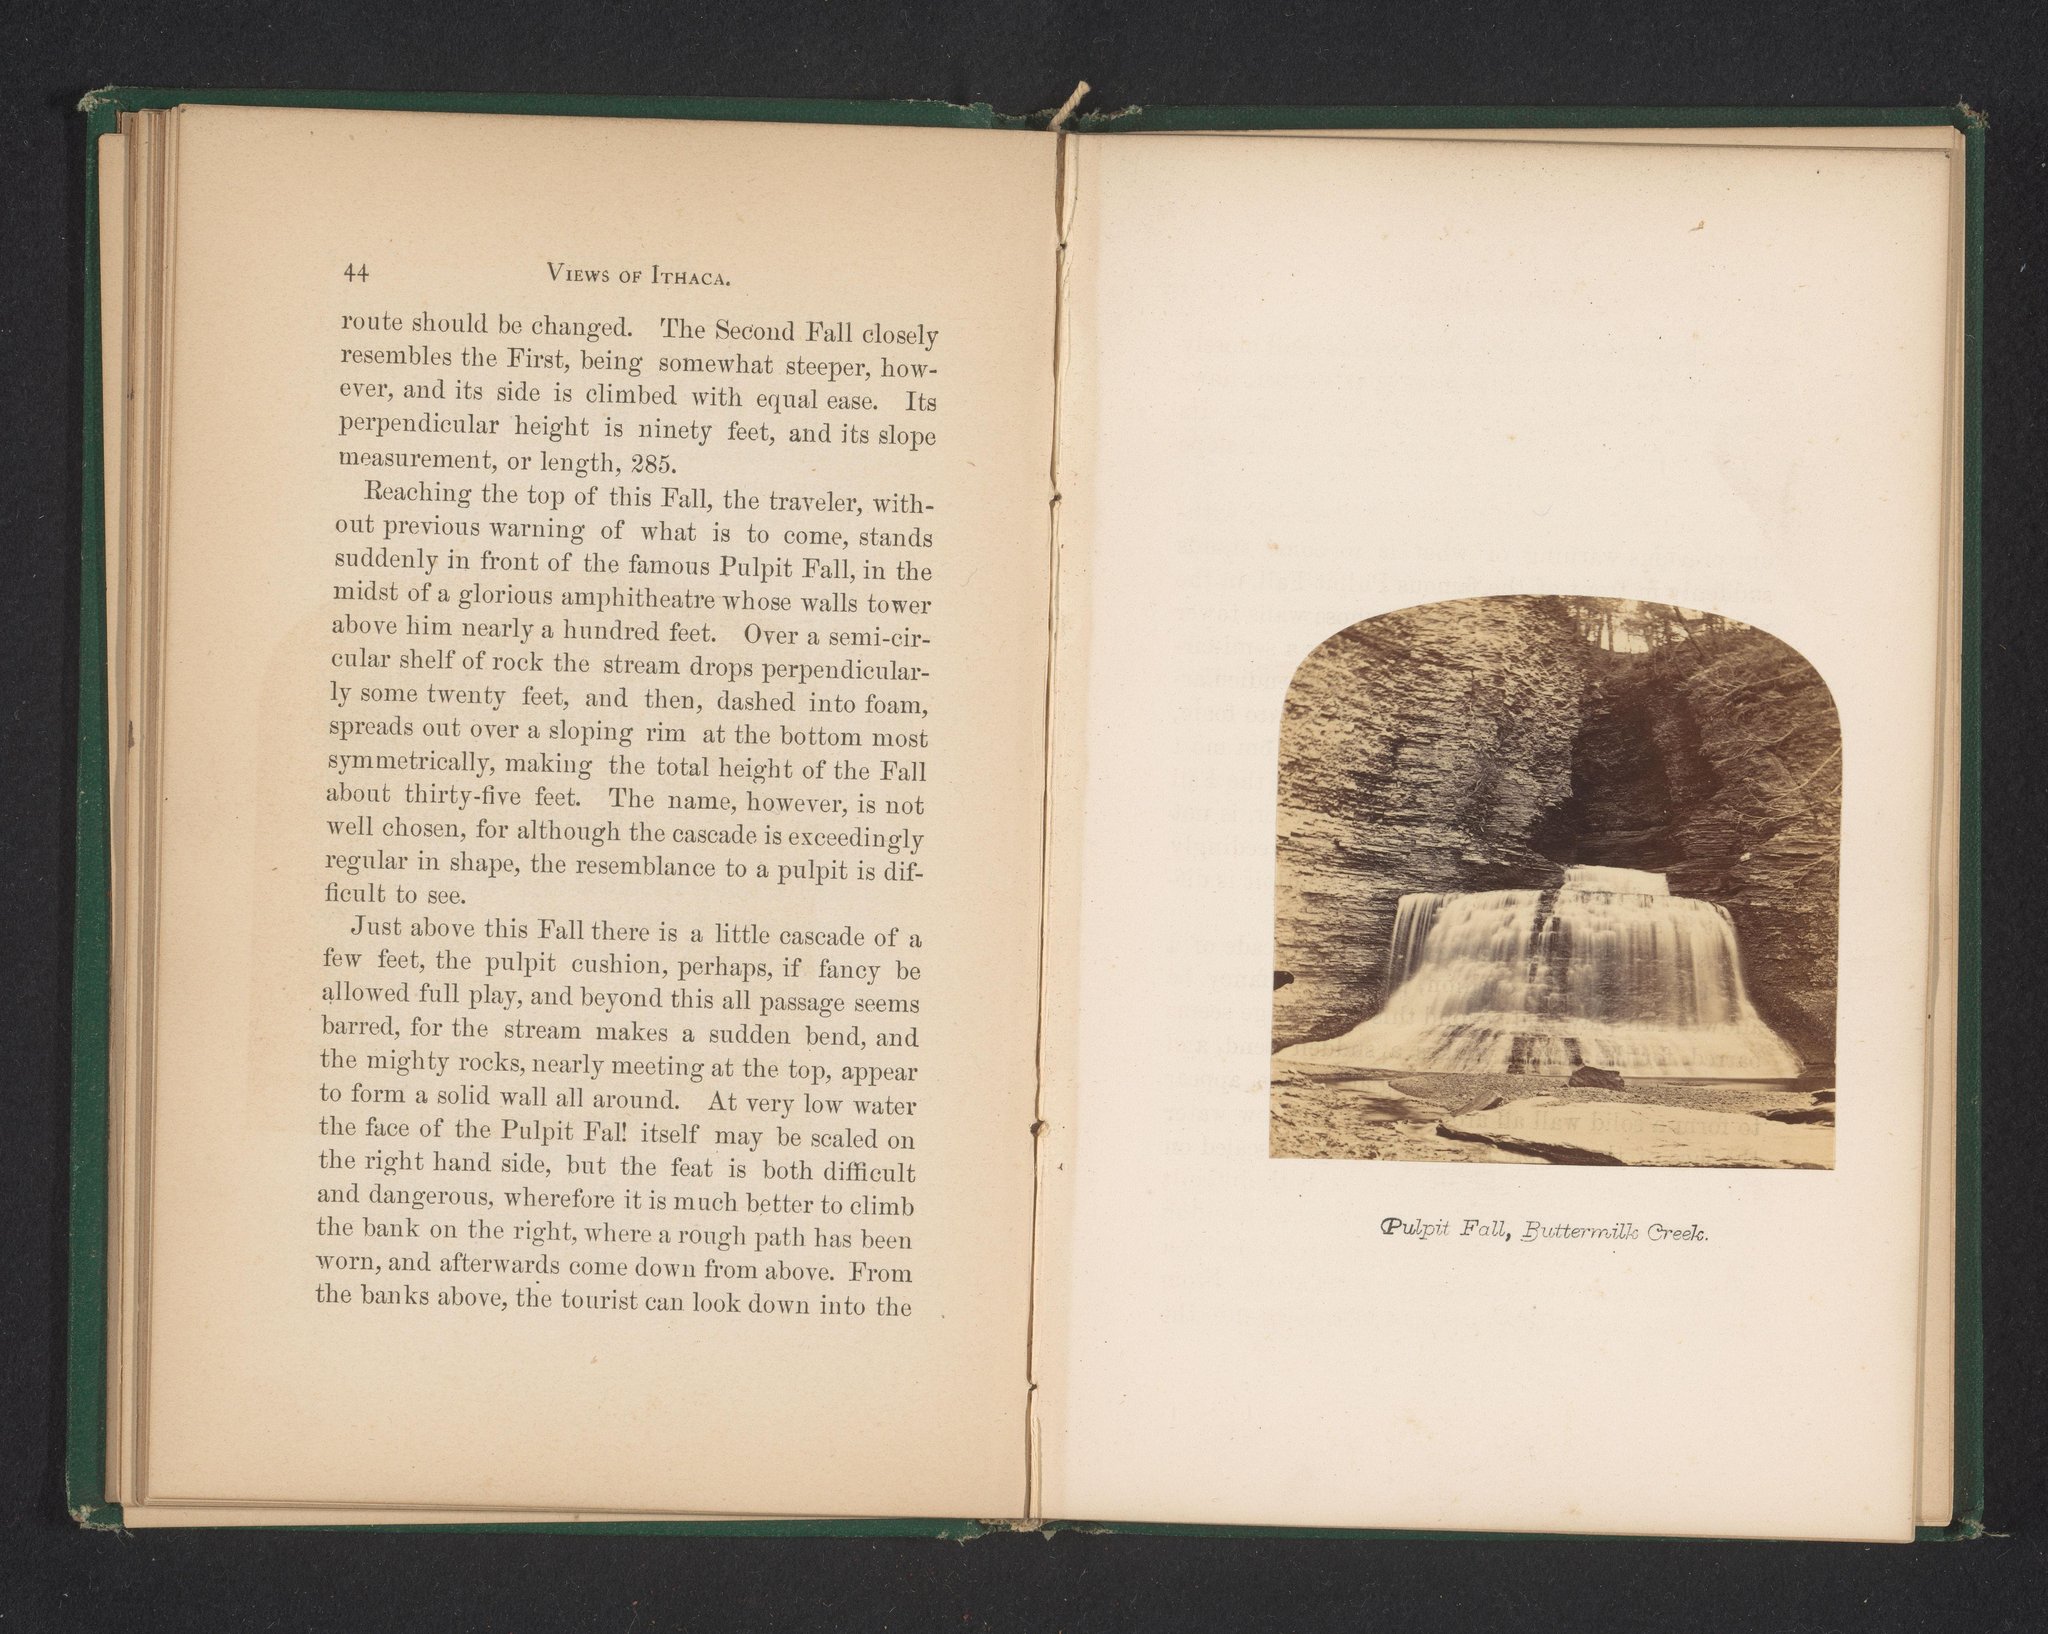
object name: page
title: Pulpit Fall, Buttermilk Creek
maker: joseph curtiss burritt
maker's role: fotograaf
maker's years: 1817-1889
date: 1864-1869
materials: photographic support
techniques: albumen print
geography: new york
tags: waterfall